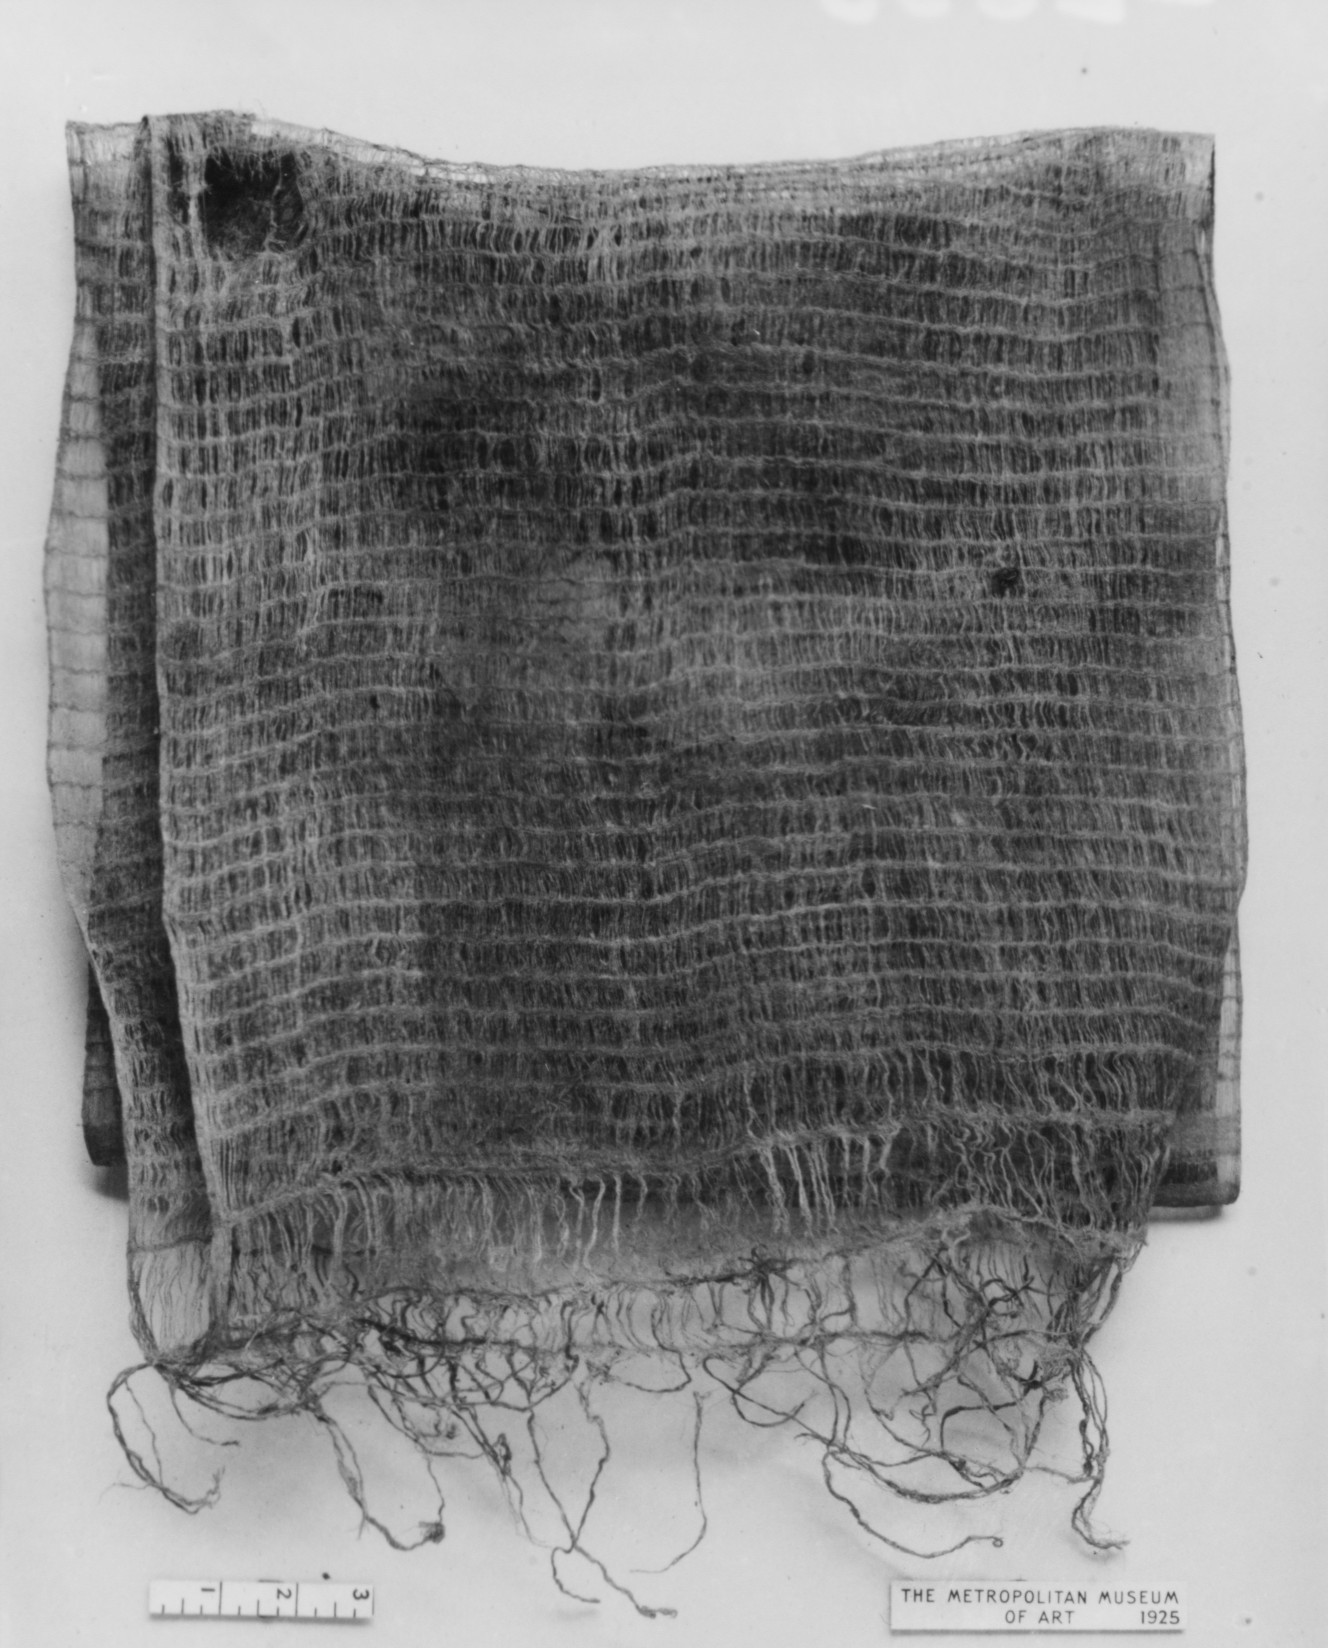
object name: openwork shawl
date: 101-333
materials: linen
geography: egypt